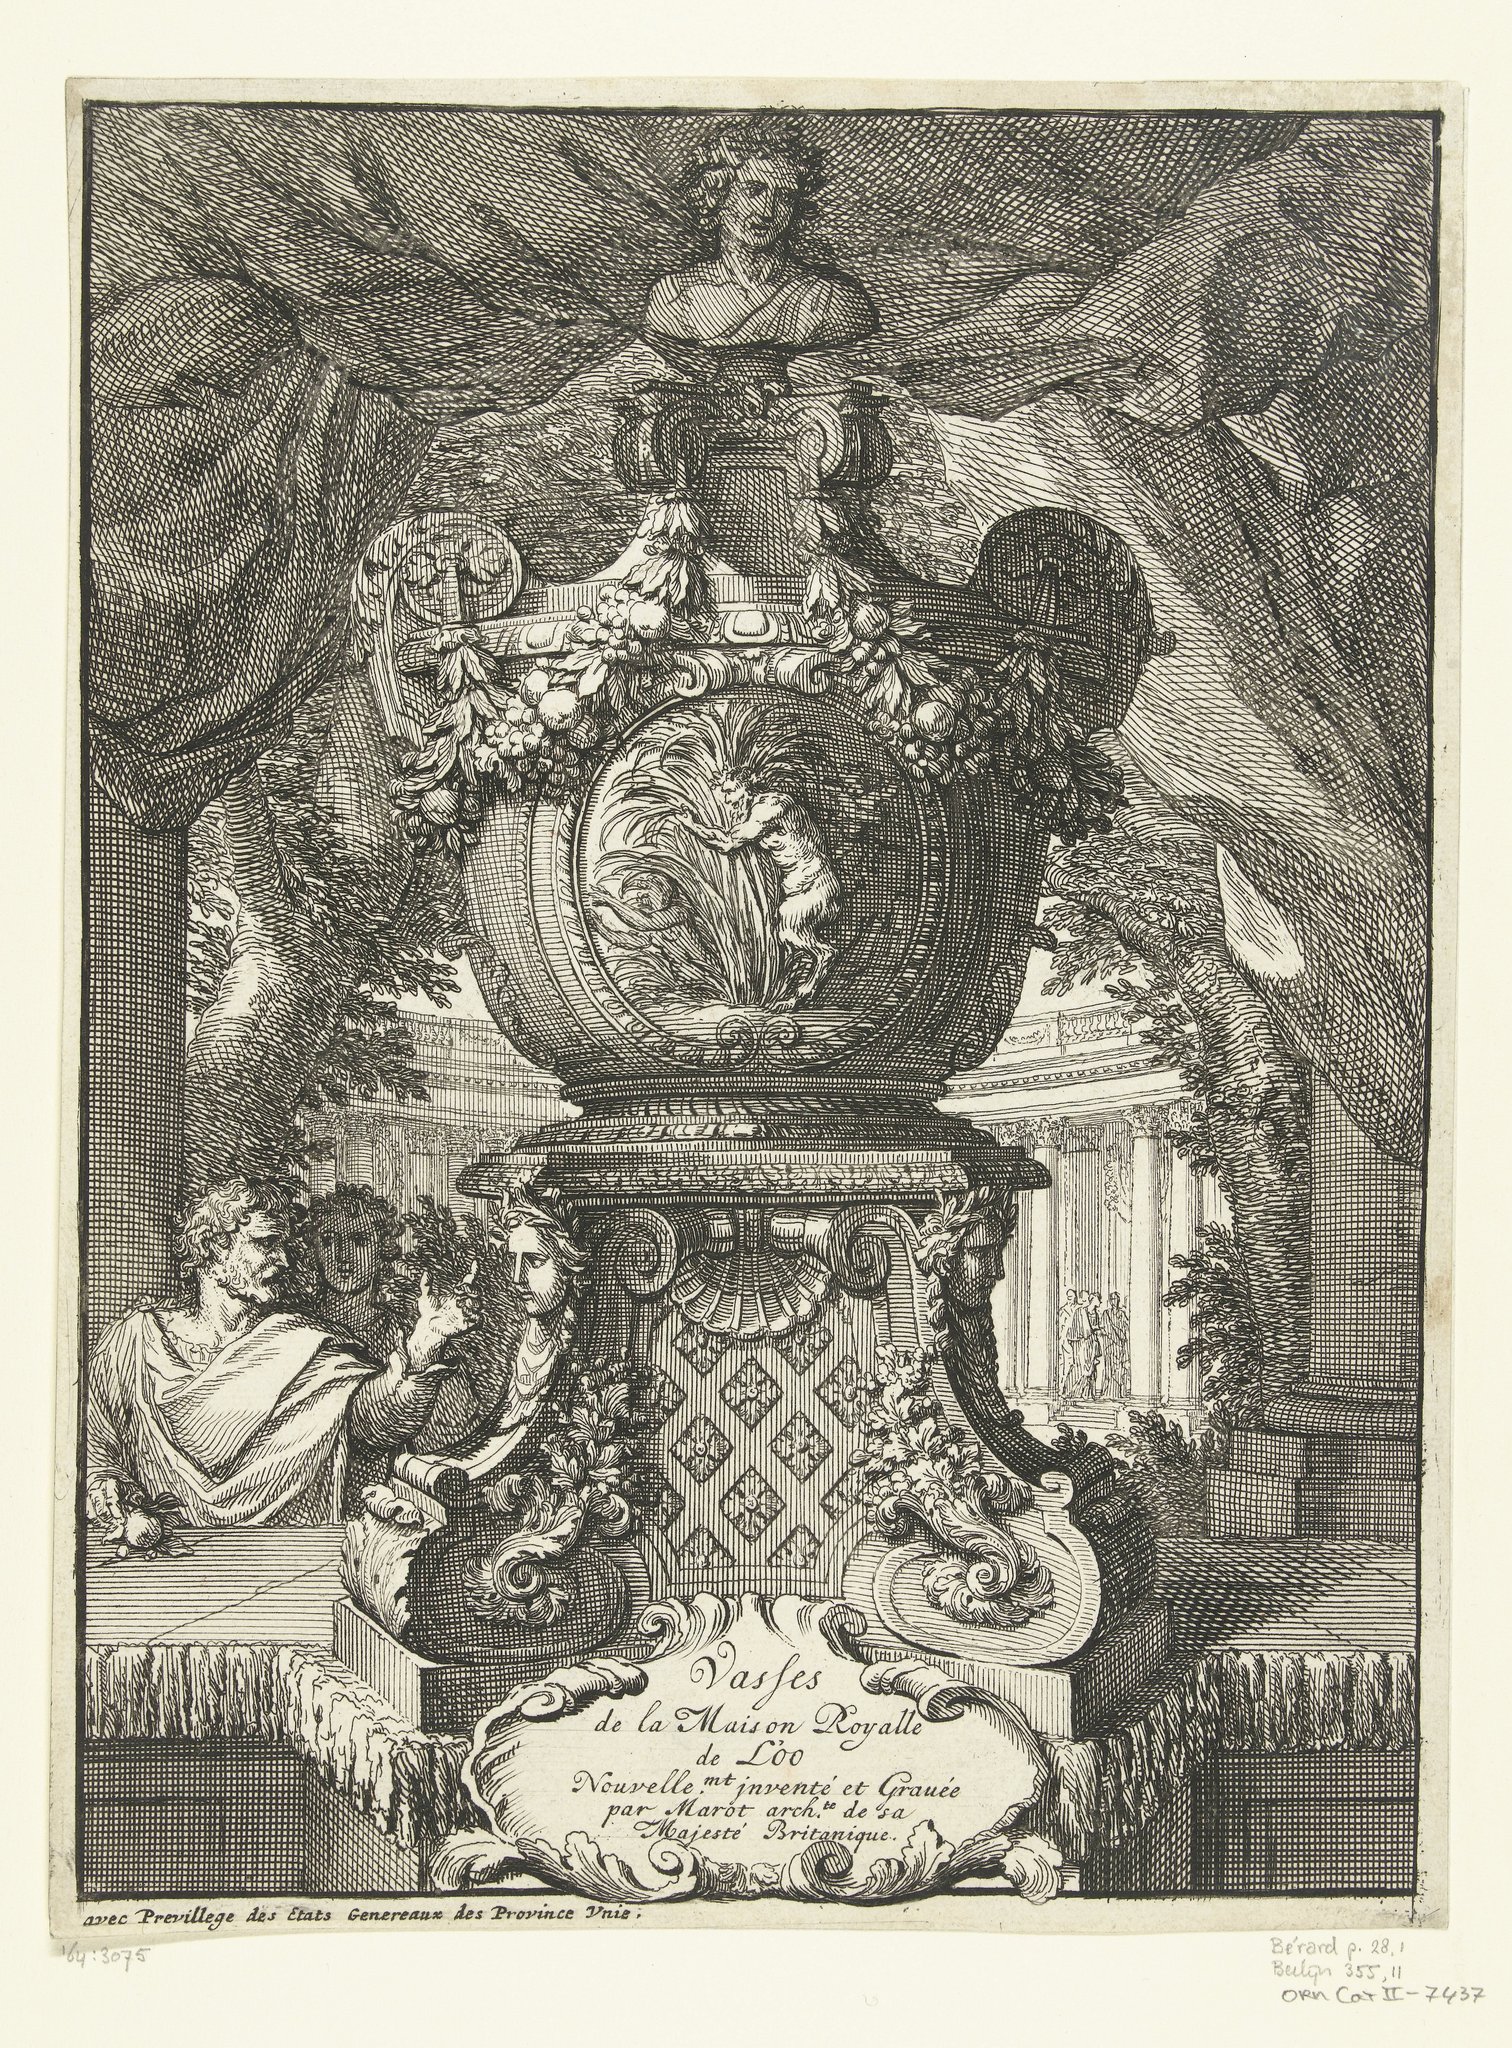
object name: print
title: Titelblad: Vasses de la Maison Royalle de L'oo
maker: daniël marot (i)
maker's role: draughtsman, print maker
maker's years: 1661-1752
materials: paper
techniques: etching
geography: the hague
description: Vaas op een voetstuk, gedecoreerd met een bas-reliëf en bekroond met een buste. Blad uit serie van 6 bladen met tuinvazen van Paleis Het Loo.